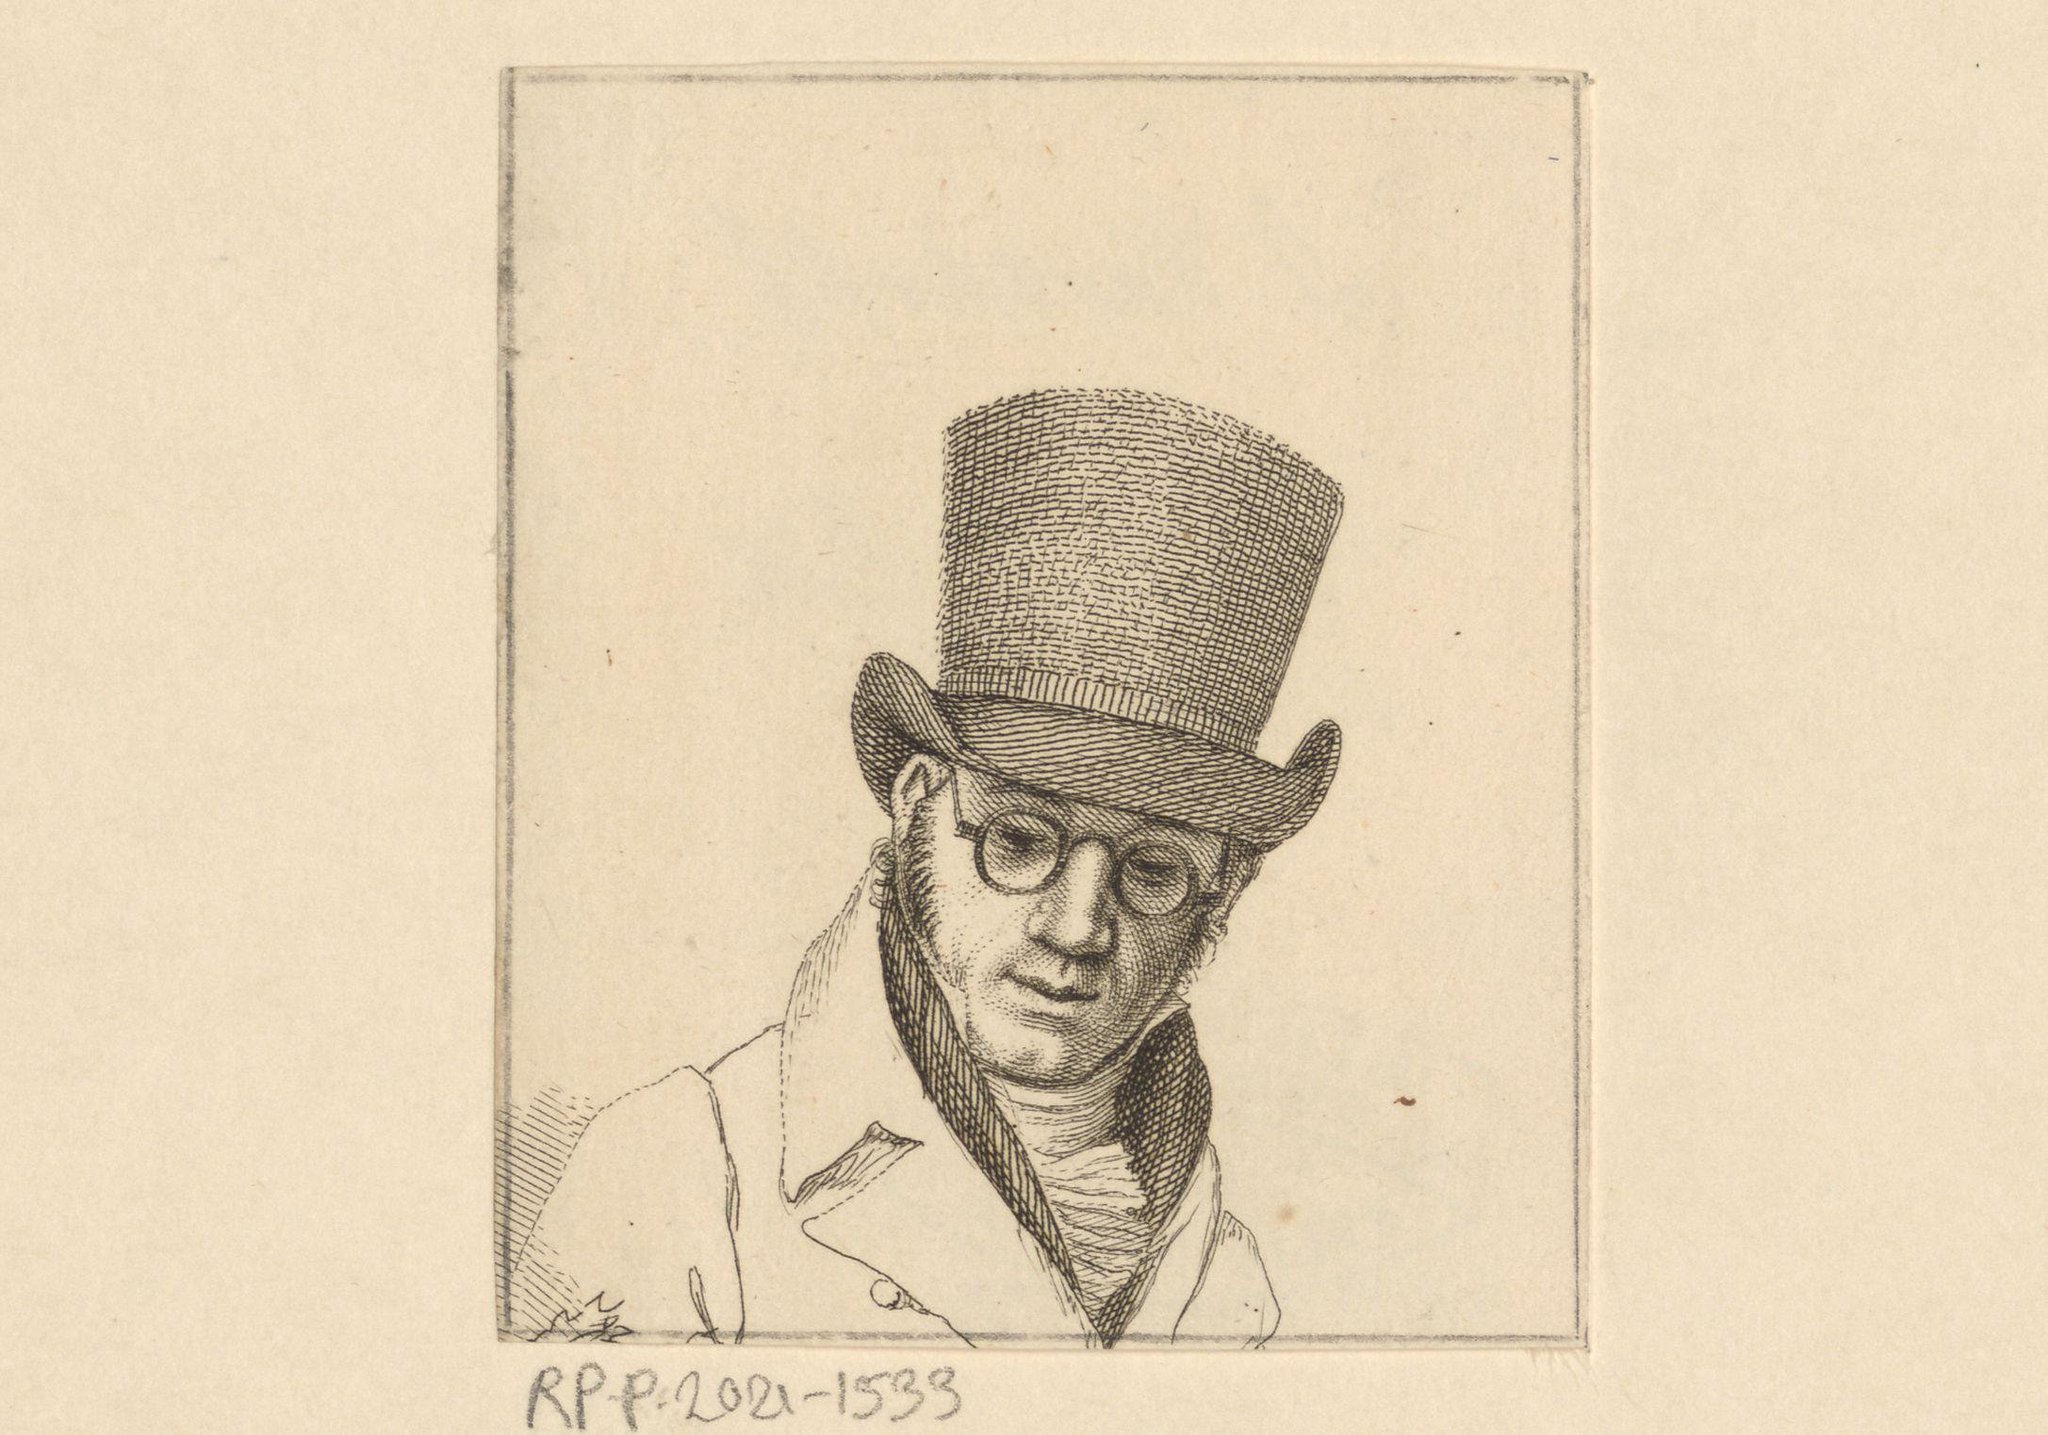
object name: print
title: Portret van Daniël Kerkhoff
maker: jacob ernst marcus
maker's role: draughtsman, print maker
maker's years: 1774-1826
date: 1811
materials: paper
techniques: etching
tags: amsterdam, draughtsman, daniël kerkhoff, historical persons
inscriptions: collector's mark: Lugt 924